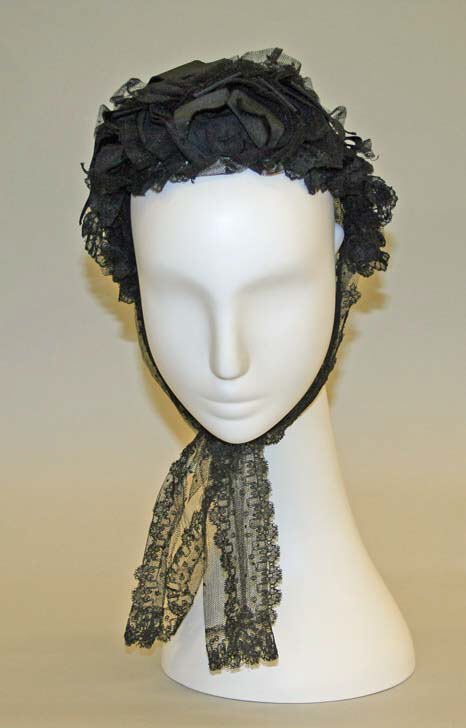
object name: cap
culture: american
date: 1863-1865